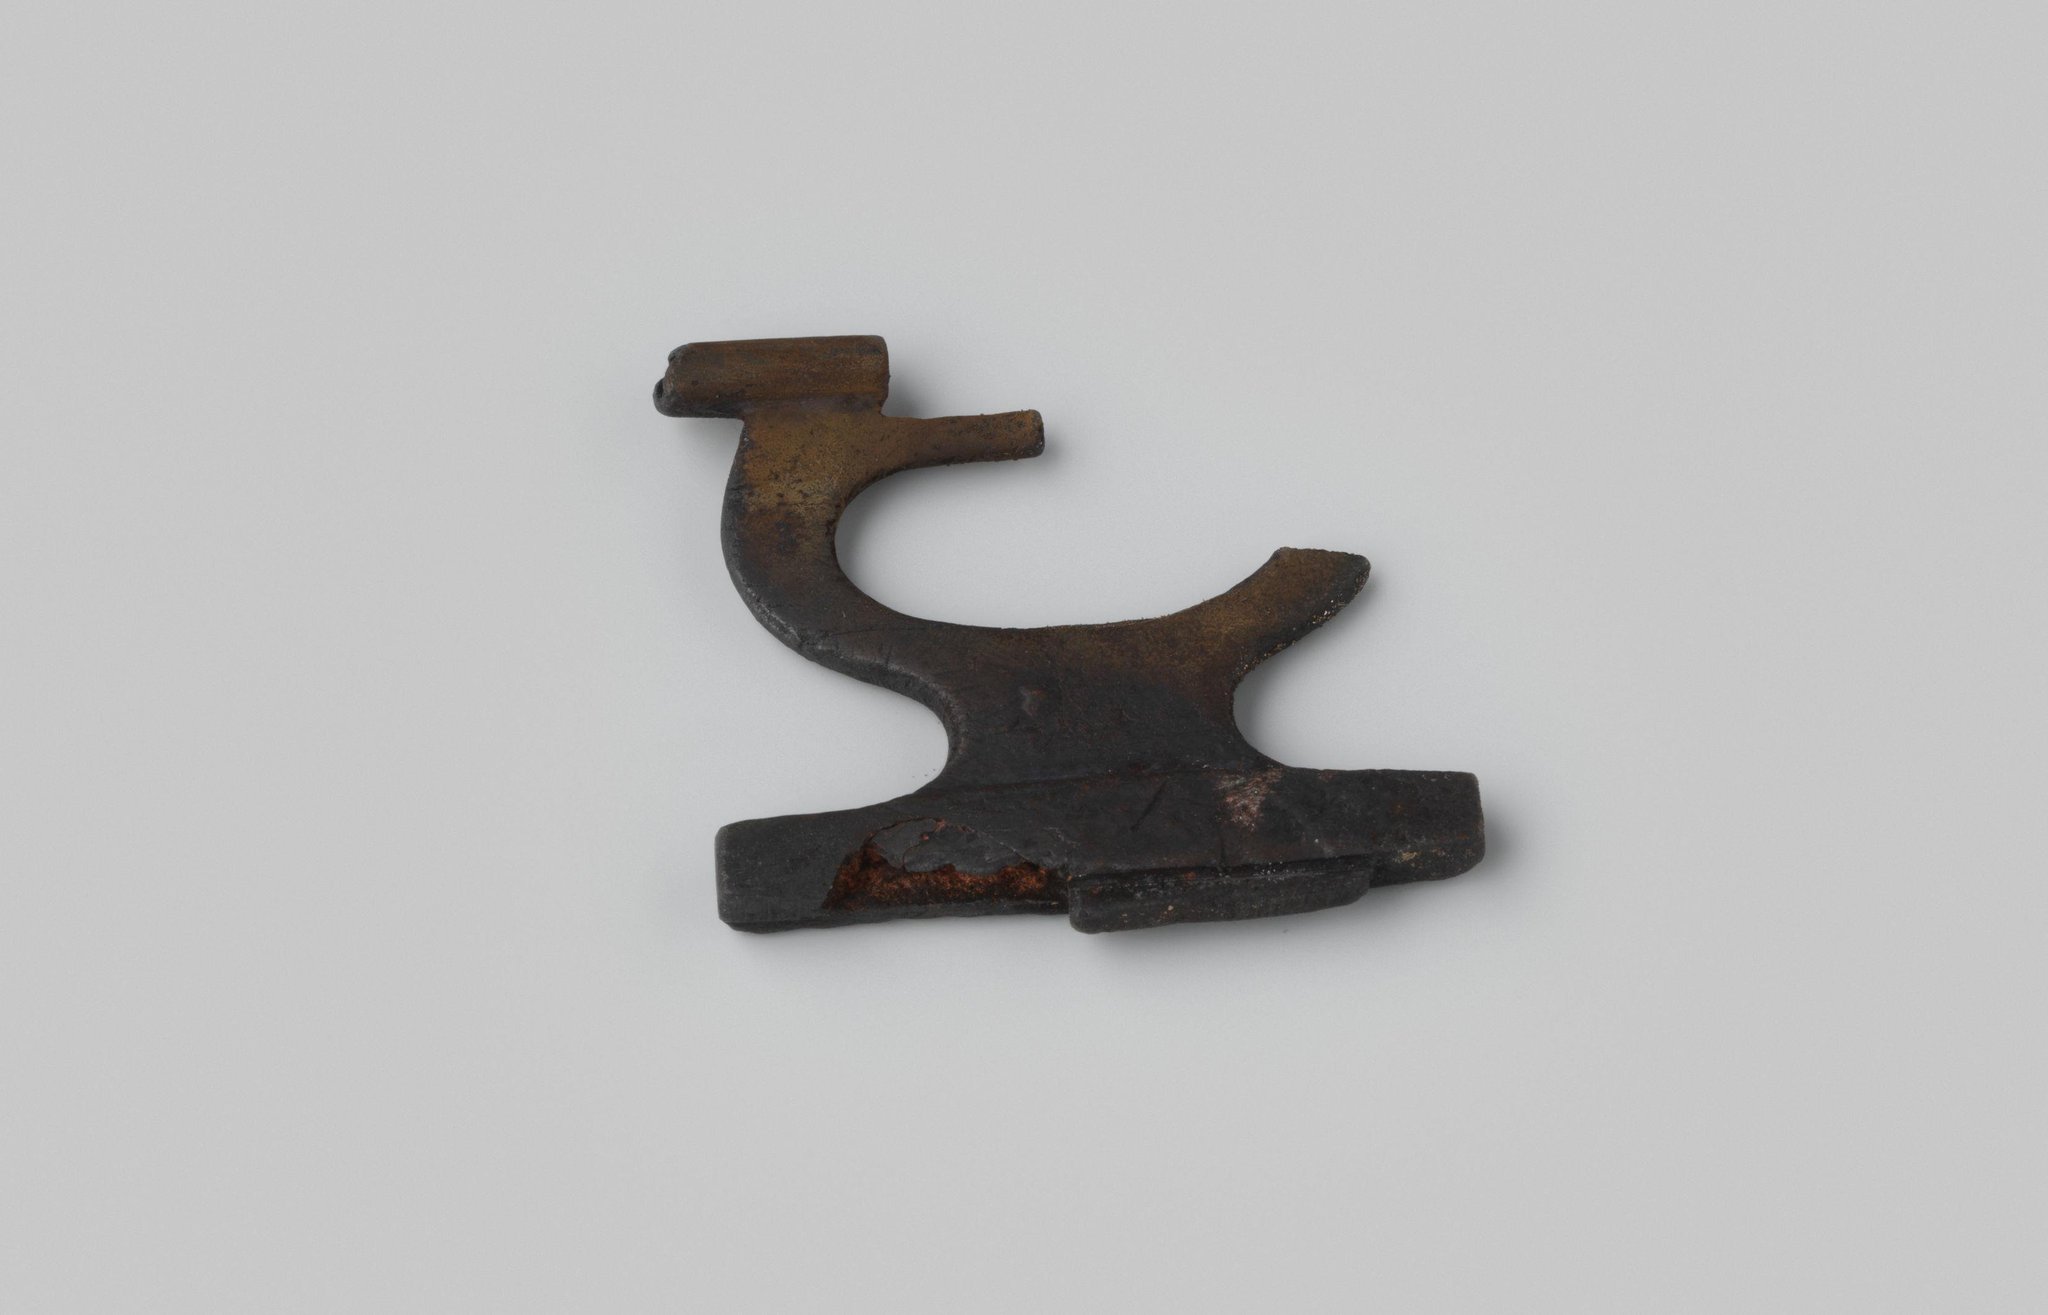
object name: clasp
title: Sluithaak uit het wrak van de Oost-Indiëvaarder Hollandia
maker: Anonymous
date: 1700-1743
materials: copper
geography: netherlands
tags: verenigde oostindische compagnie, hollandia (schip), annet